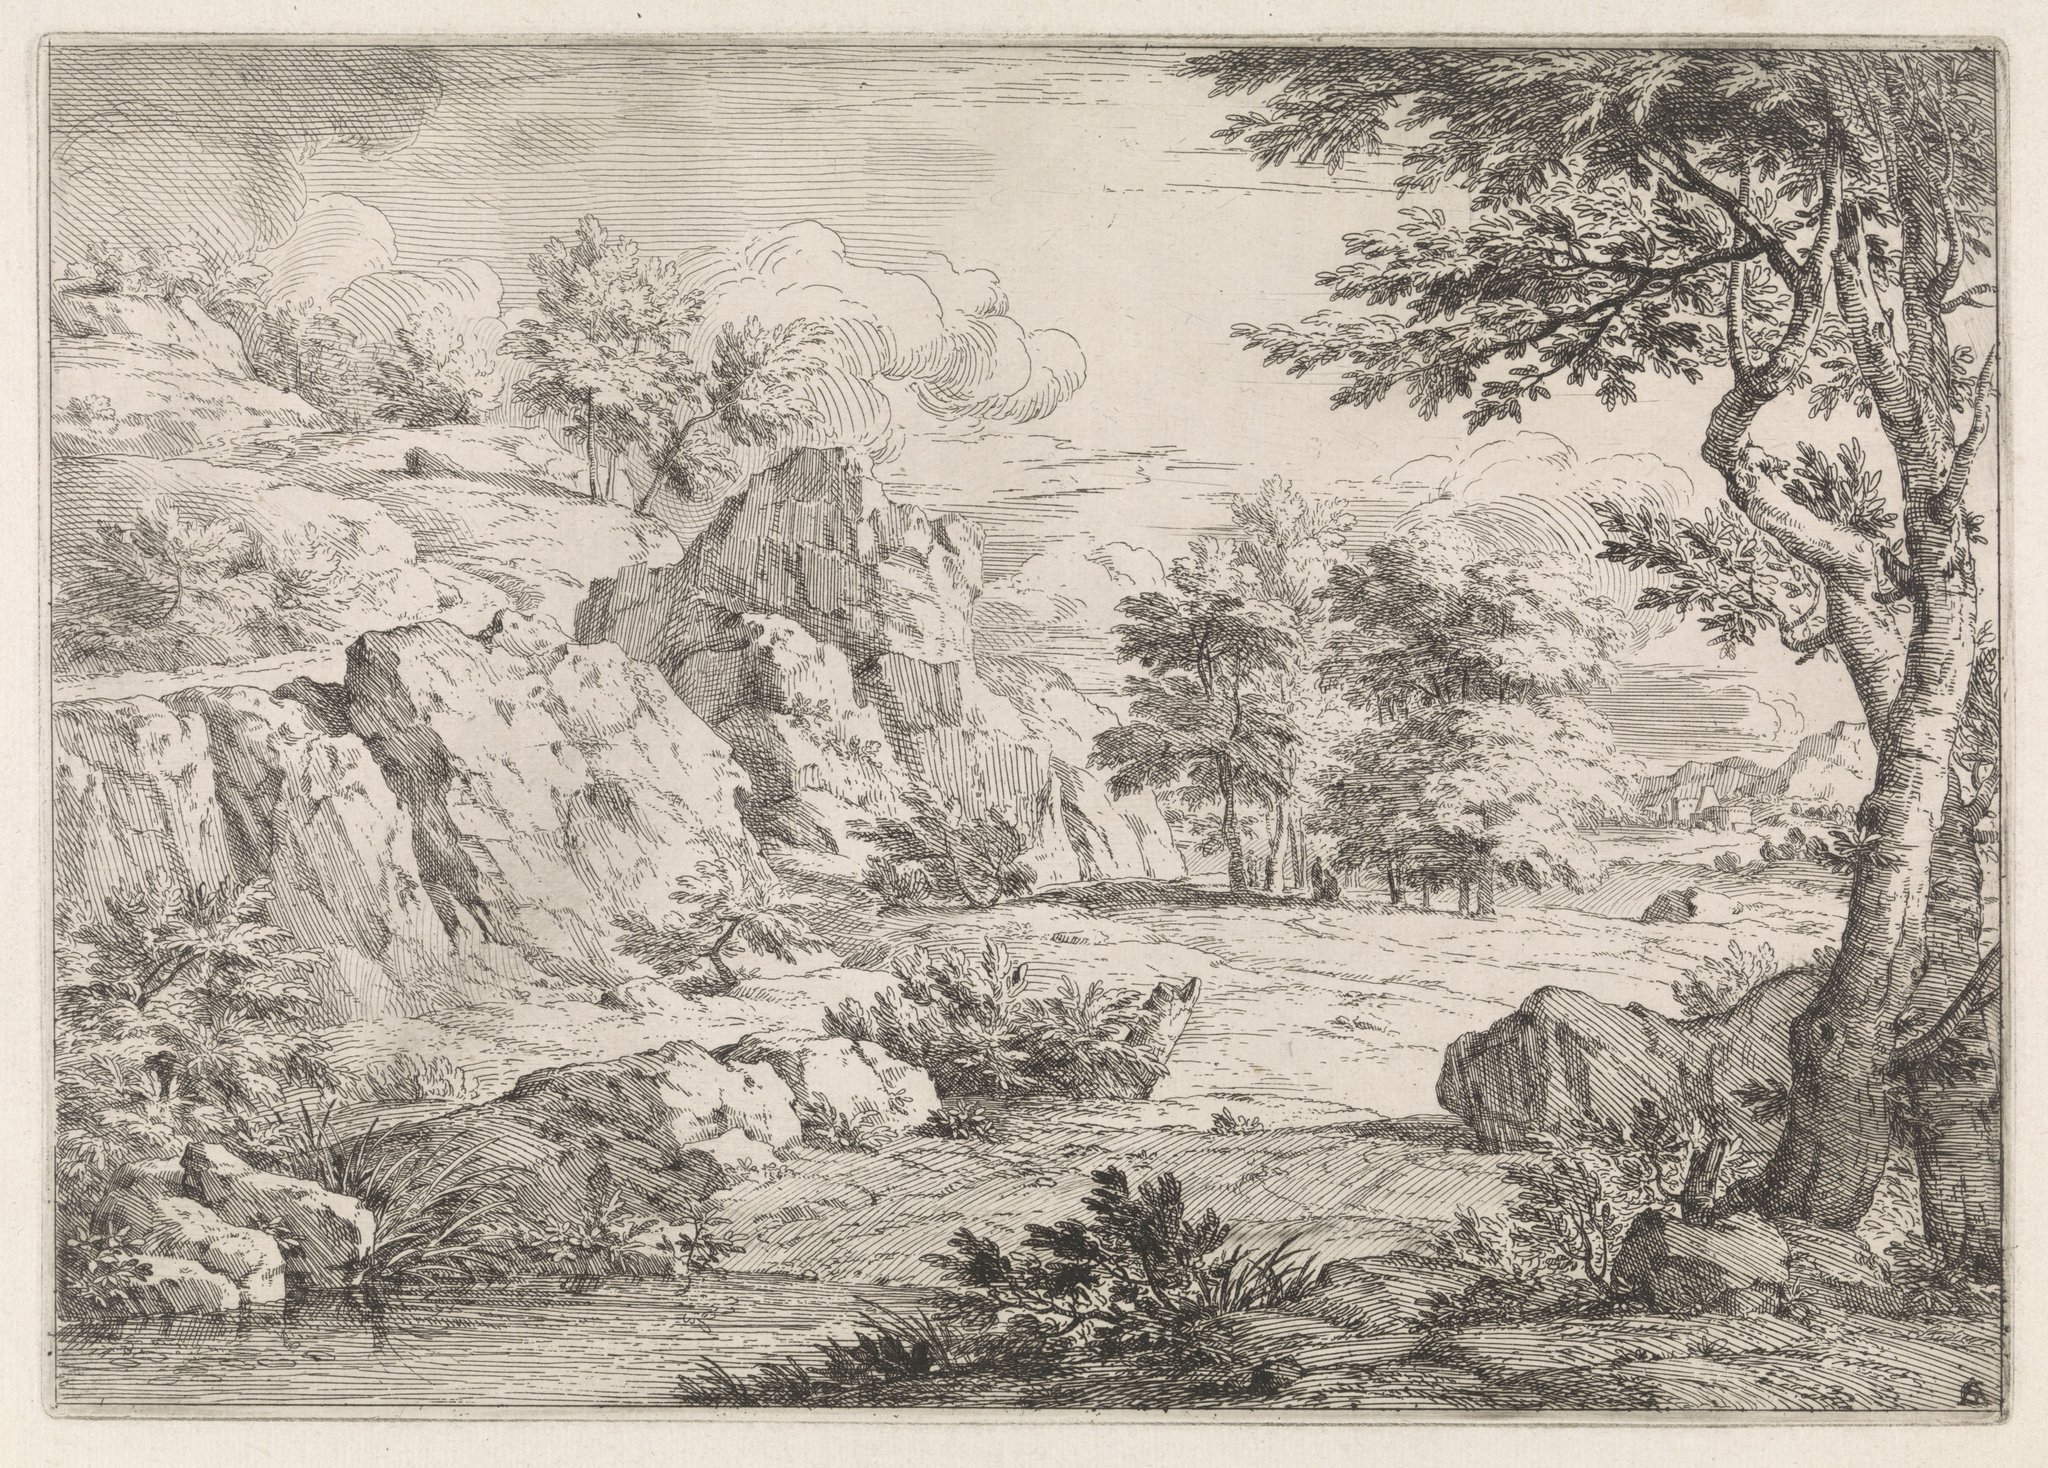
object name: print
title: Heuvellandschap met vijver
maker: abraham genoels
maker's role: draughtsman, print maker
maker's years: 1640-1723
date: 1650-1723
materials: paper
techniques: etching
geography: paris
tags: low hill country, meadow, pasture, pond, pool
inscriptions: collector's mark: Lugt 240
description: Een heuvelachtig landschap met op de voorgrond een vijver. Op de achtergrond een weide.